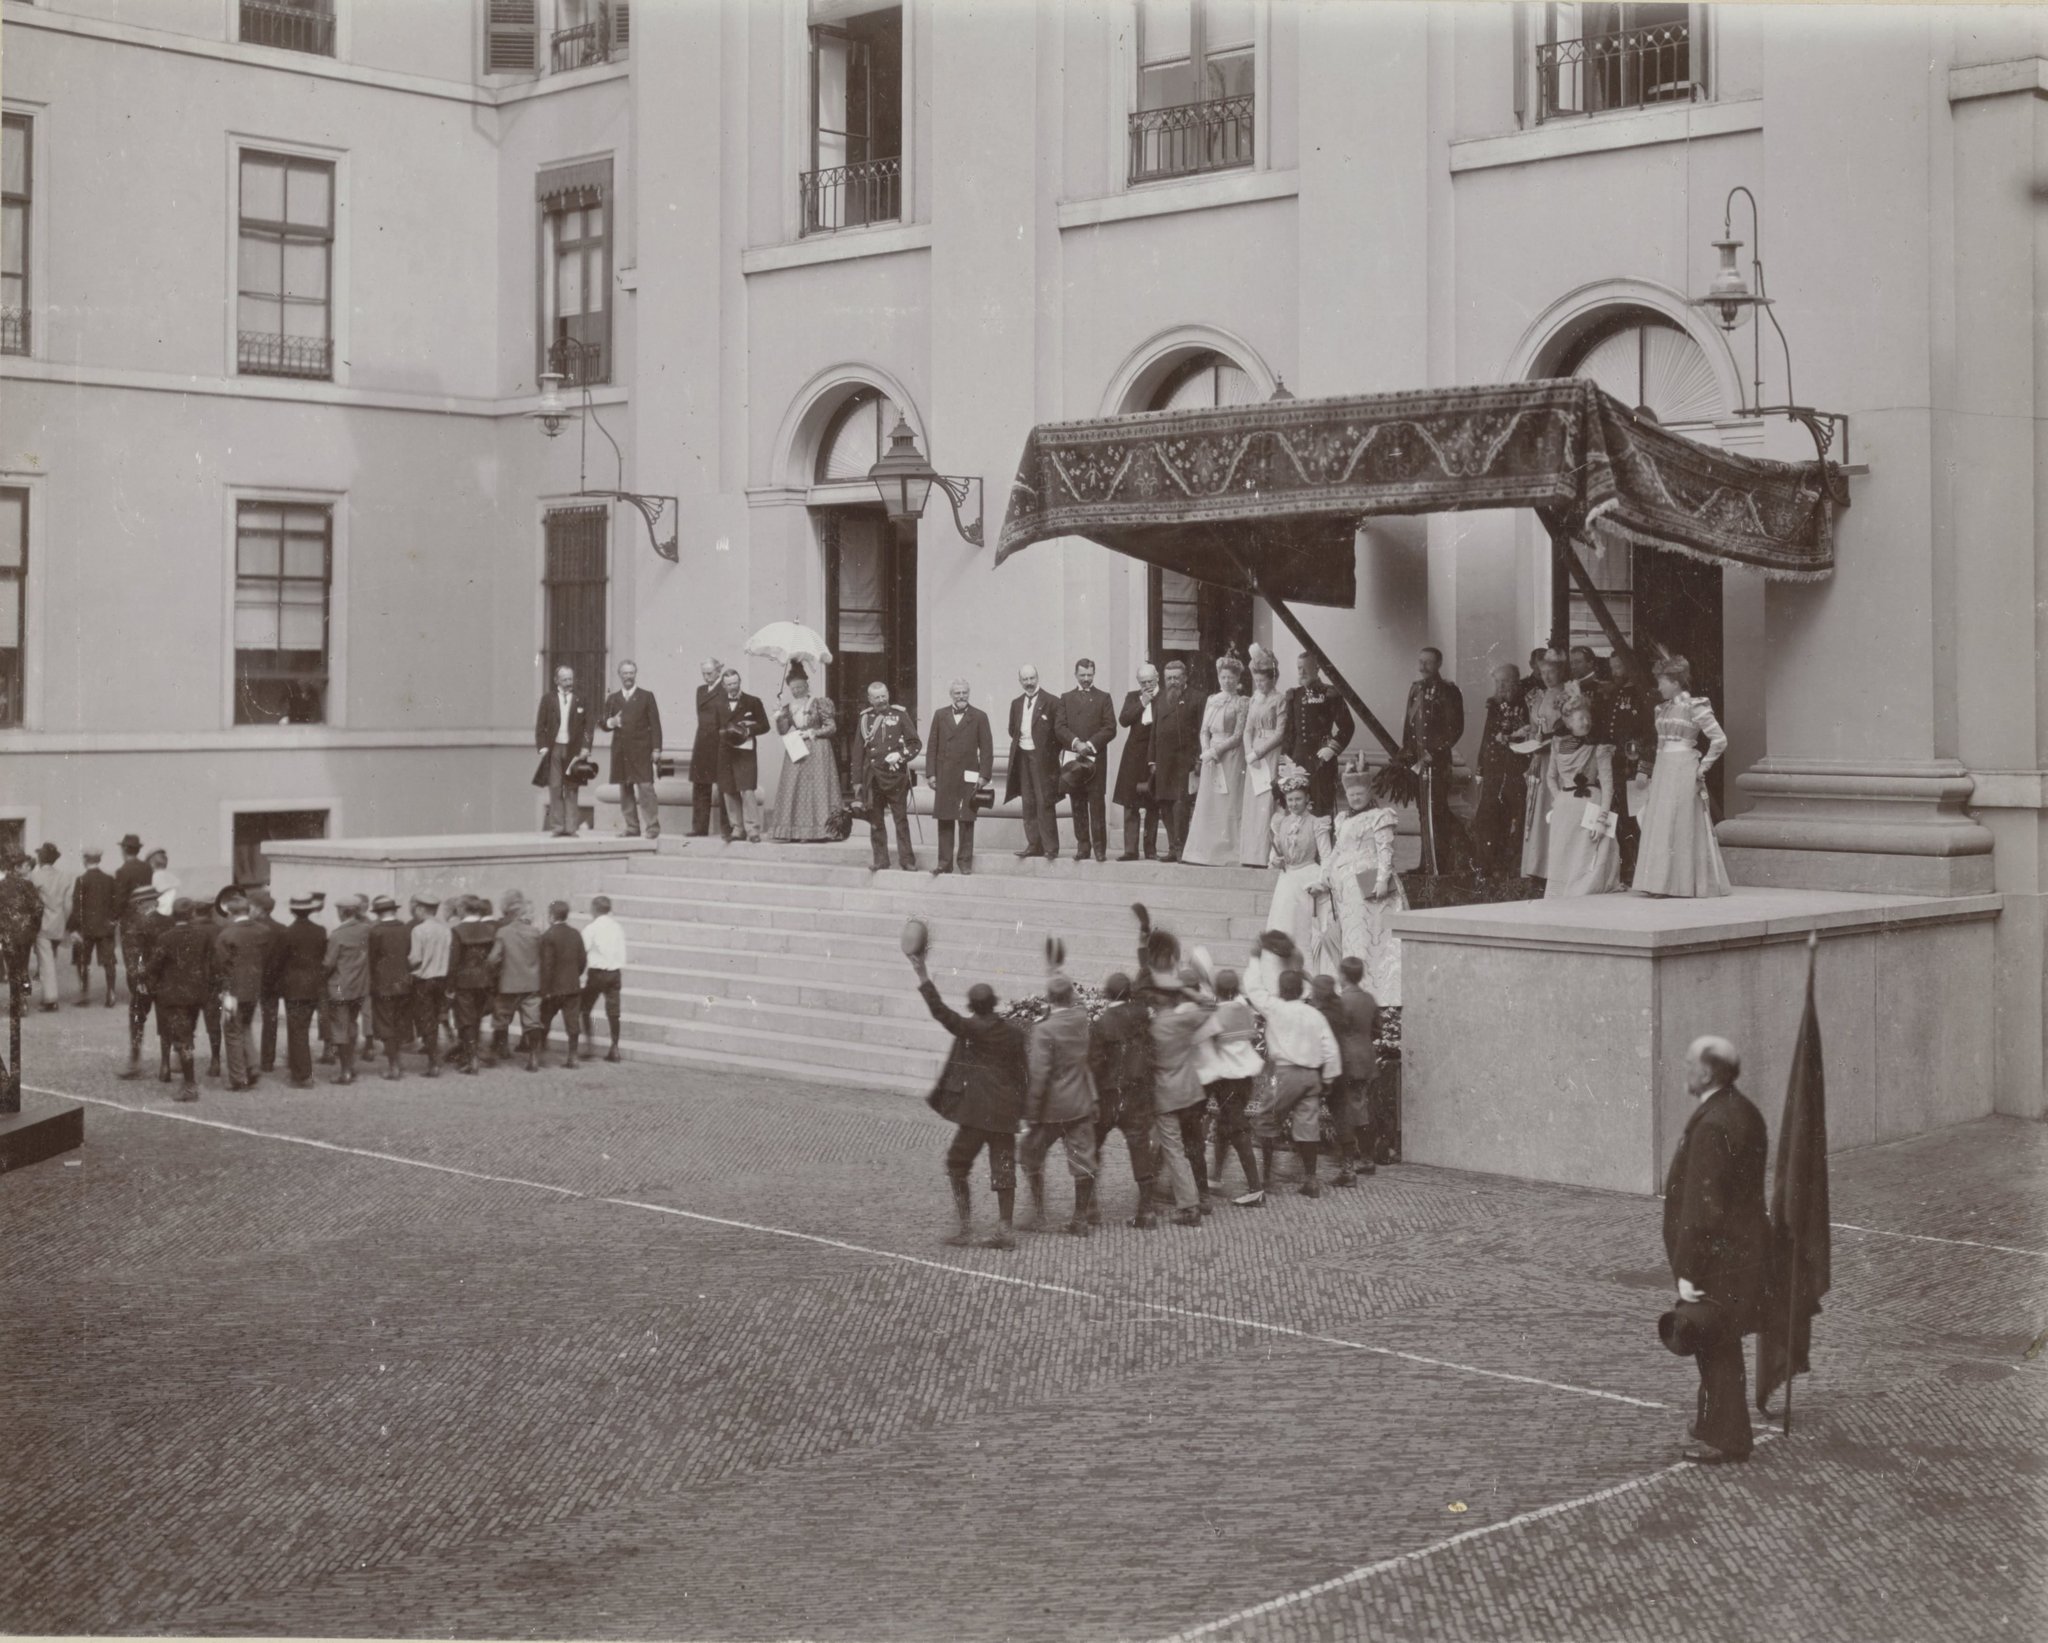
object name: photograph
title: Koningin Wilhelmina en koninginmoeder Emma op paleistrap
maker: herman deutmann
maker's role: fotograaf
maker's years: 1870-1926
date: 1890-1898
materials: cardboard, photographic support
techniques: albumen print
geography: the hague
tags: the hague, wilhelmina of the netherlands, emma (queen consort of the netherlands)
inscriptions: name: ‘H. Deutmann Art. Photographe 's Gravenhage Zeestraat 55’